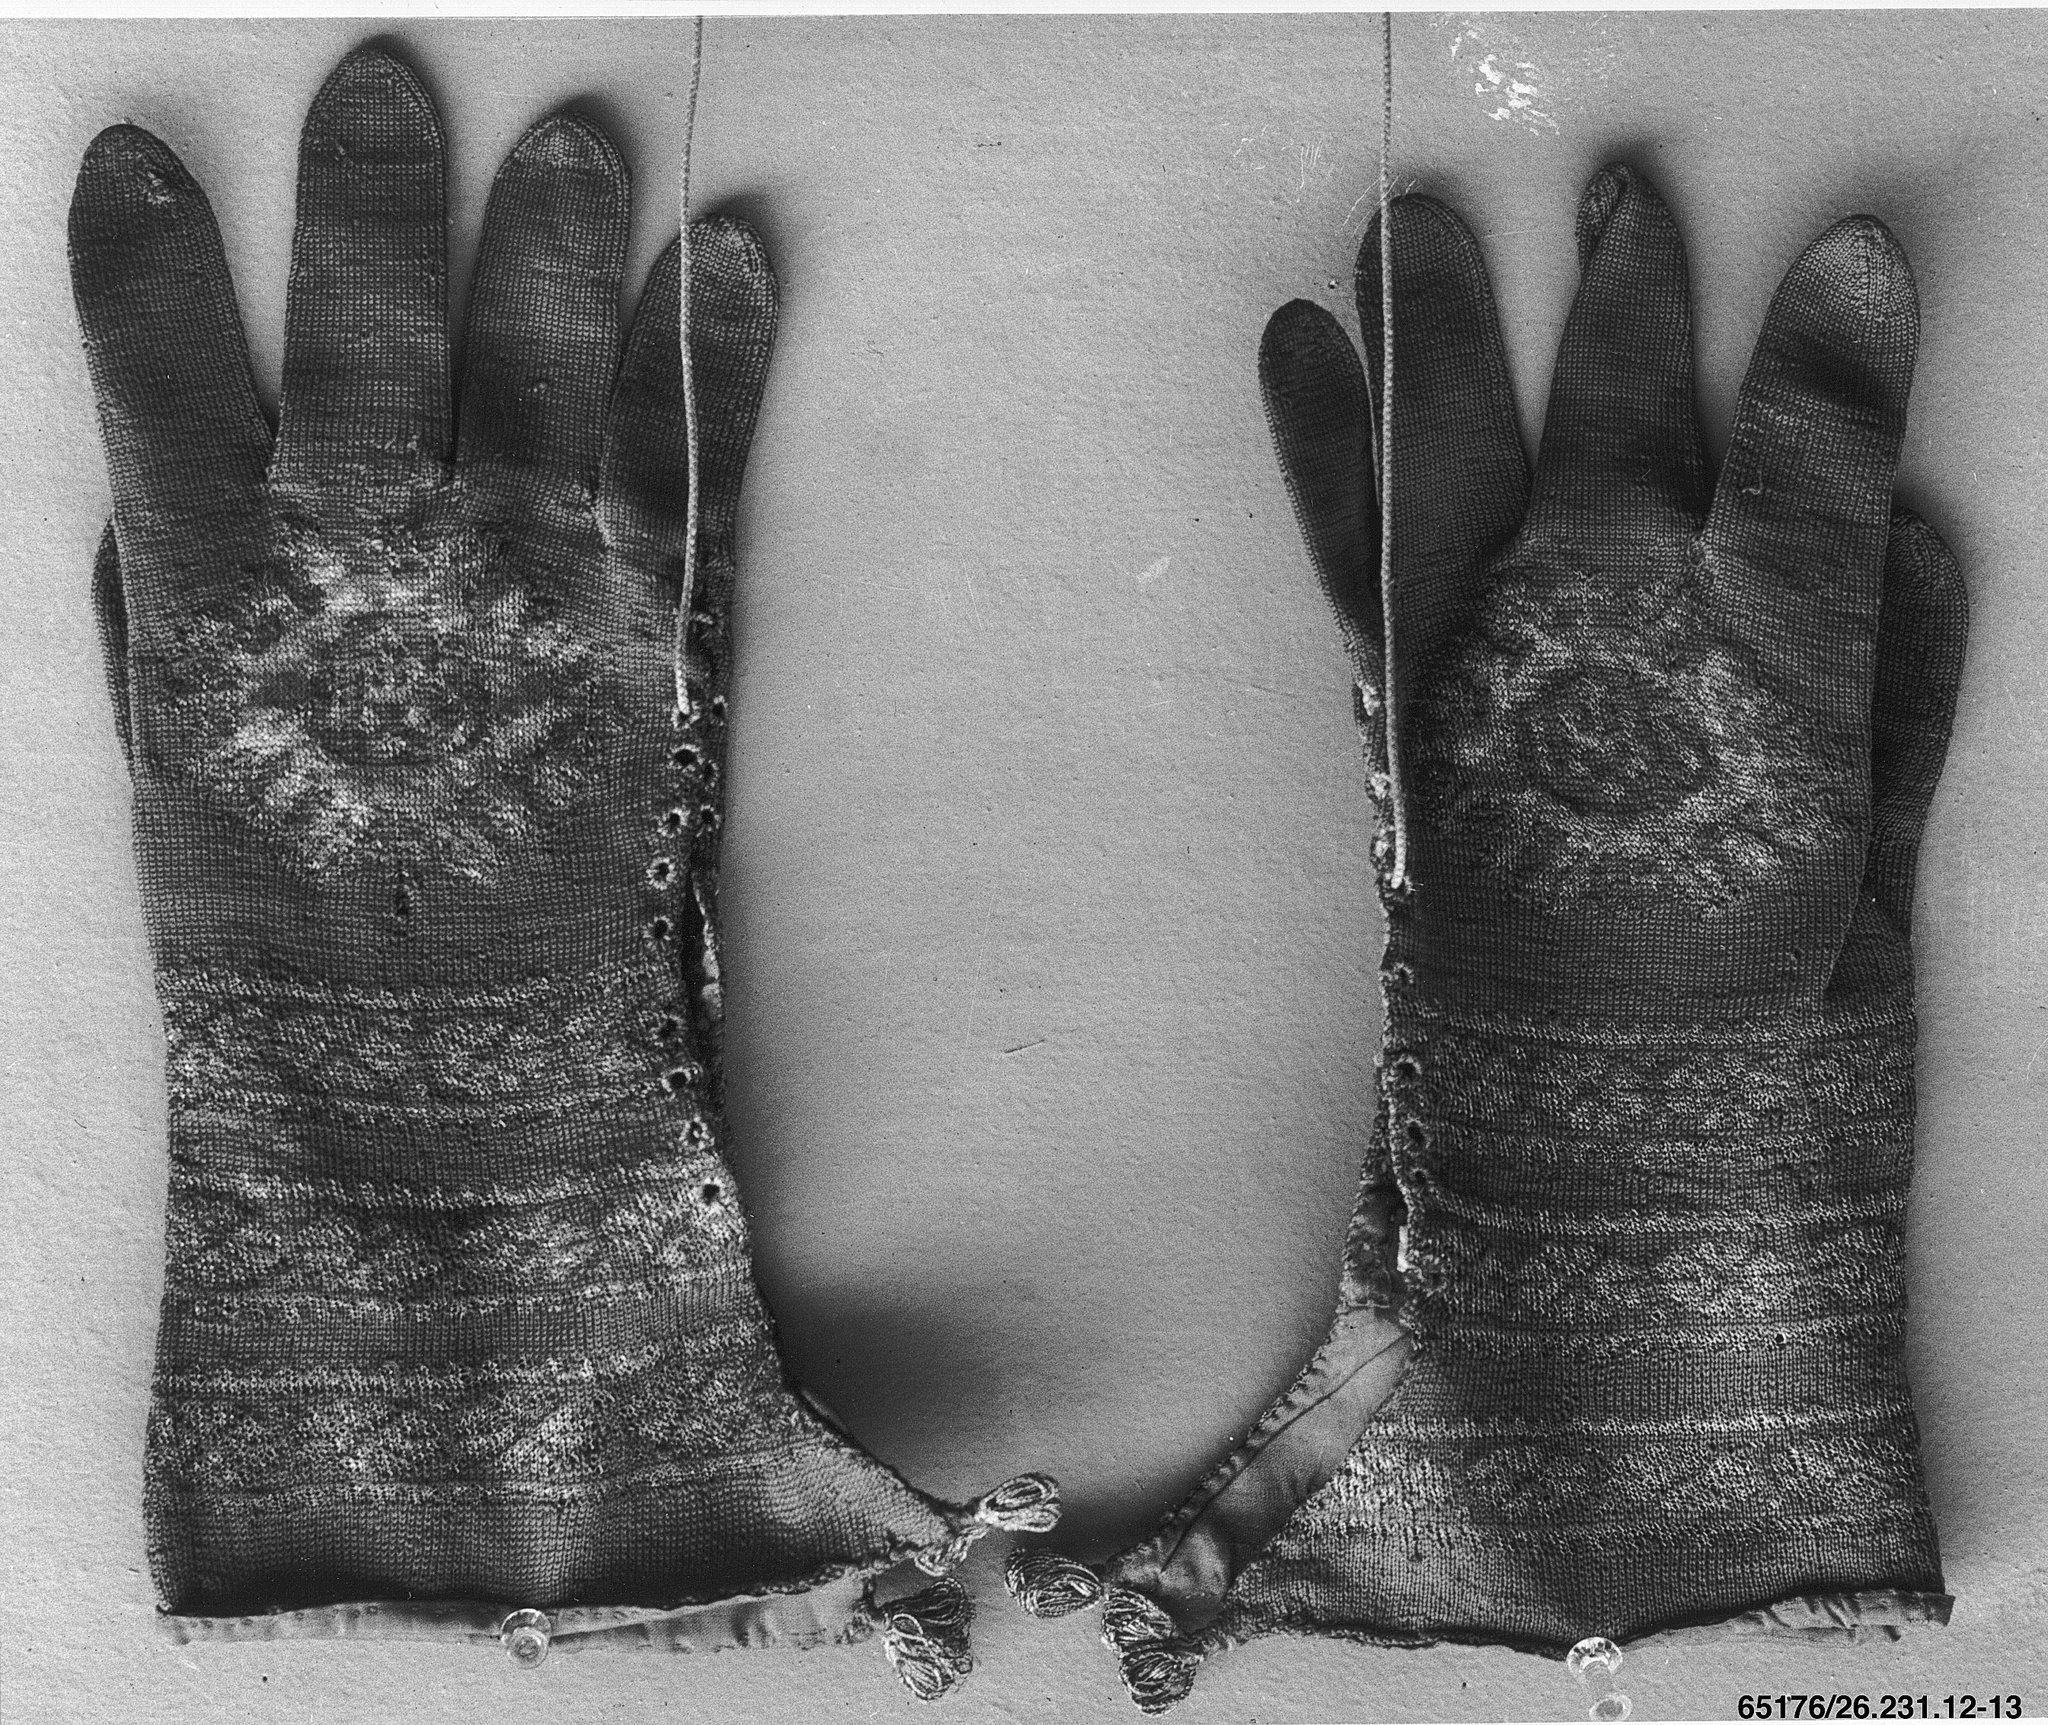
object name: glove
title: Gloves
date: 1501-1600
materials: lace, metal thread, silk